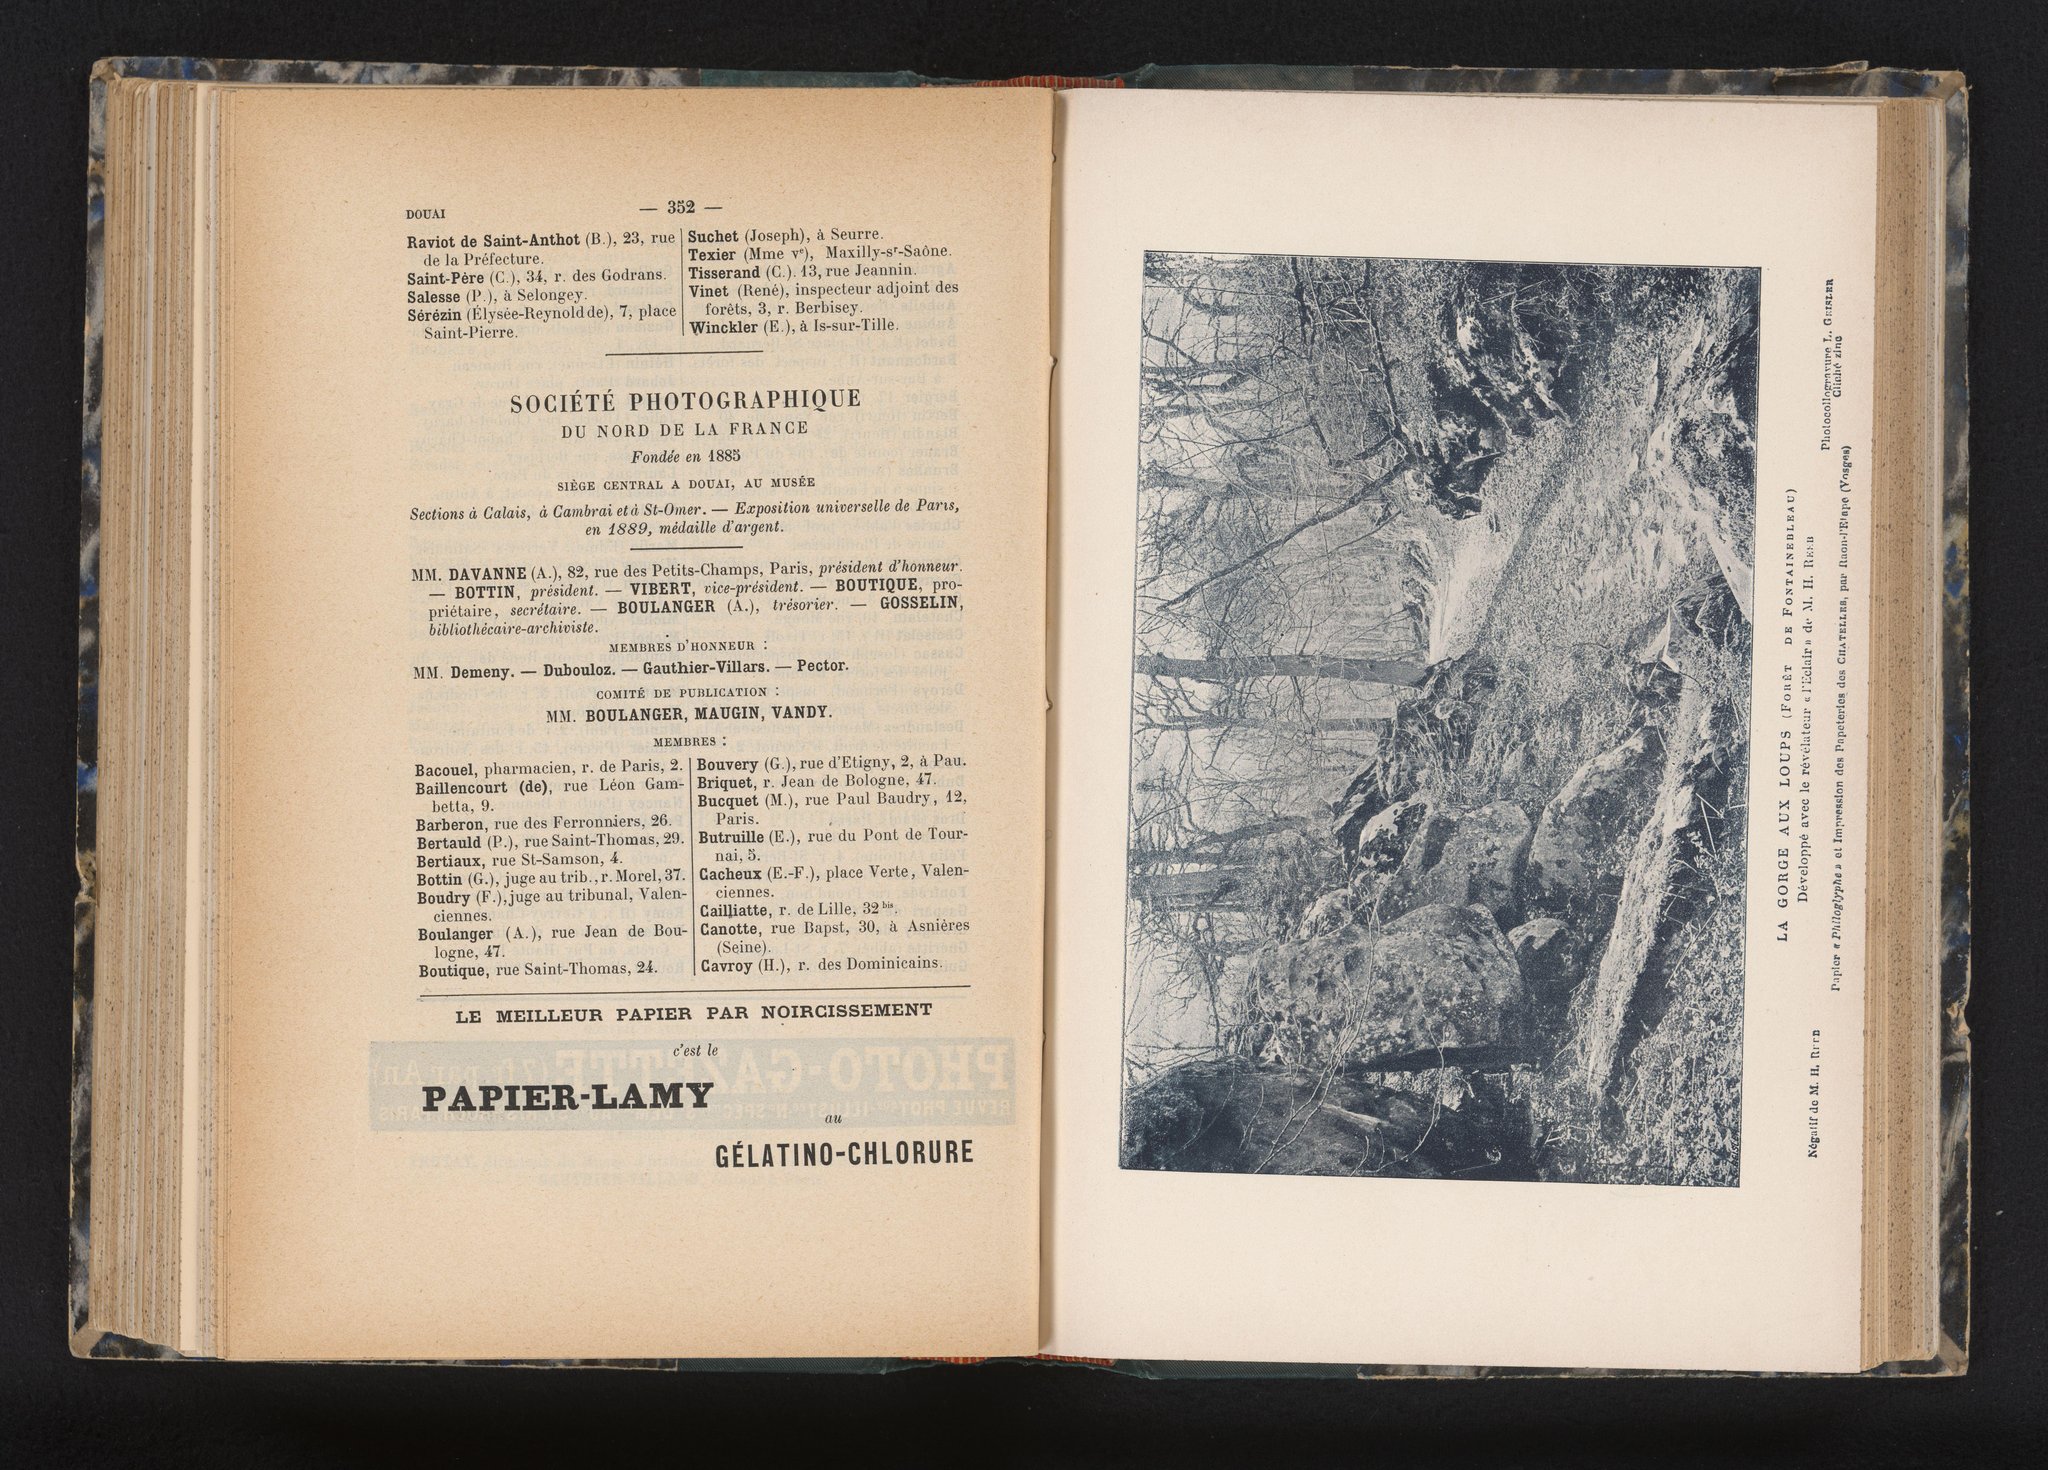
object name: page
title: La Gorge aux Loups (Forêt de Fontainebleau)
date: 1891-1896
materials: paper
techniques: autotype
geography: fontainebleau forest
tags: forest, wood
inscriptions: inscription: ‘Développé avec le révélateur << l'Eclair >> de M. H. Reeb/ Négatif de M. H. Reeb/ Photocollogravure L. Geisler/ Cliché zinc/ Papier < Philoglyphe > et Impression des Papeteries des Chatelles, par Raon-l'Etape (Vosges)’